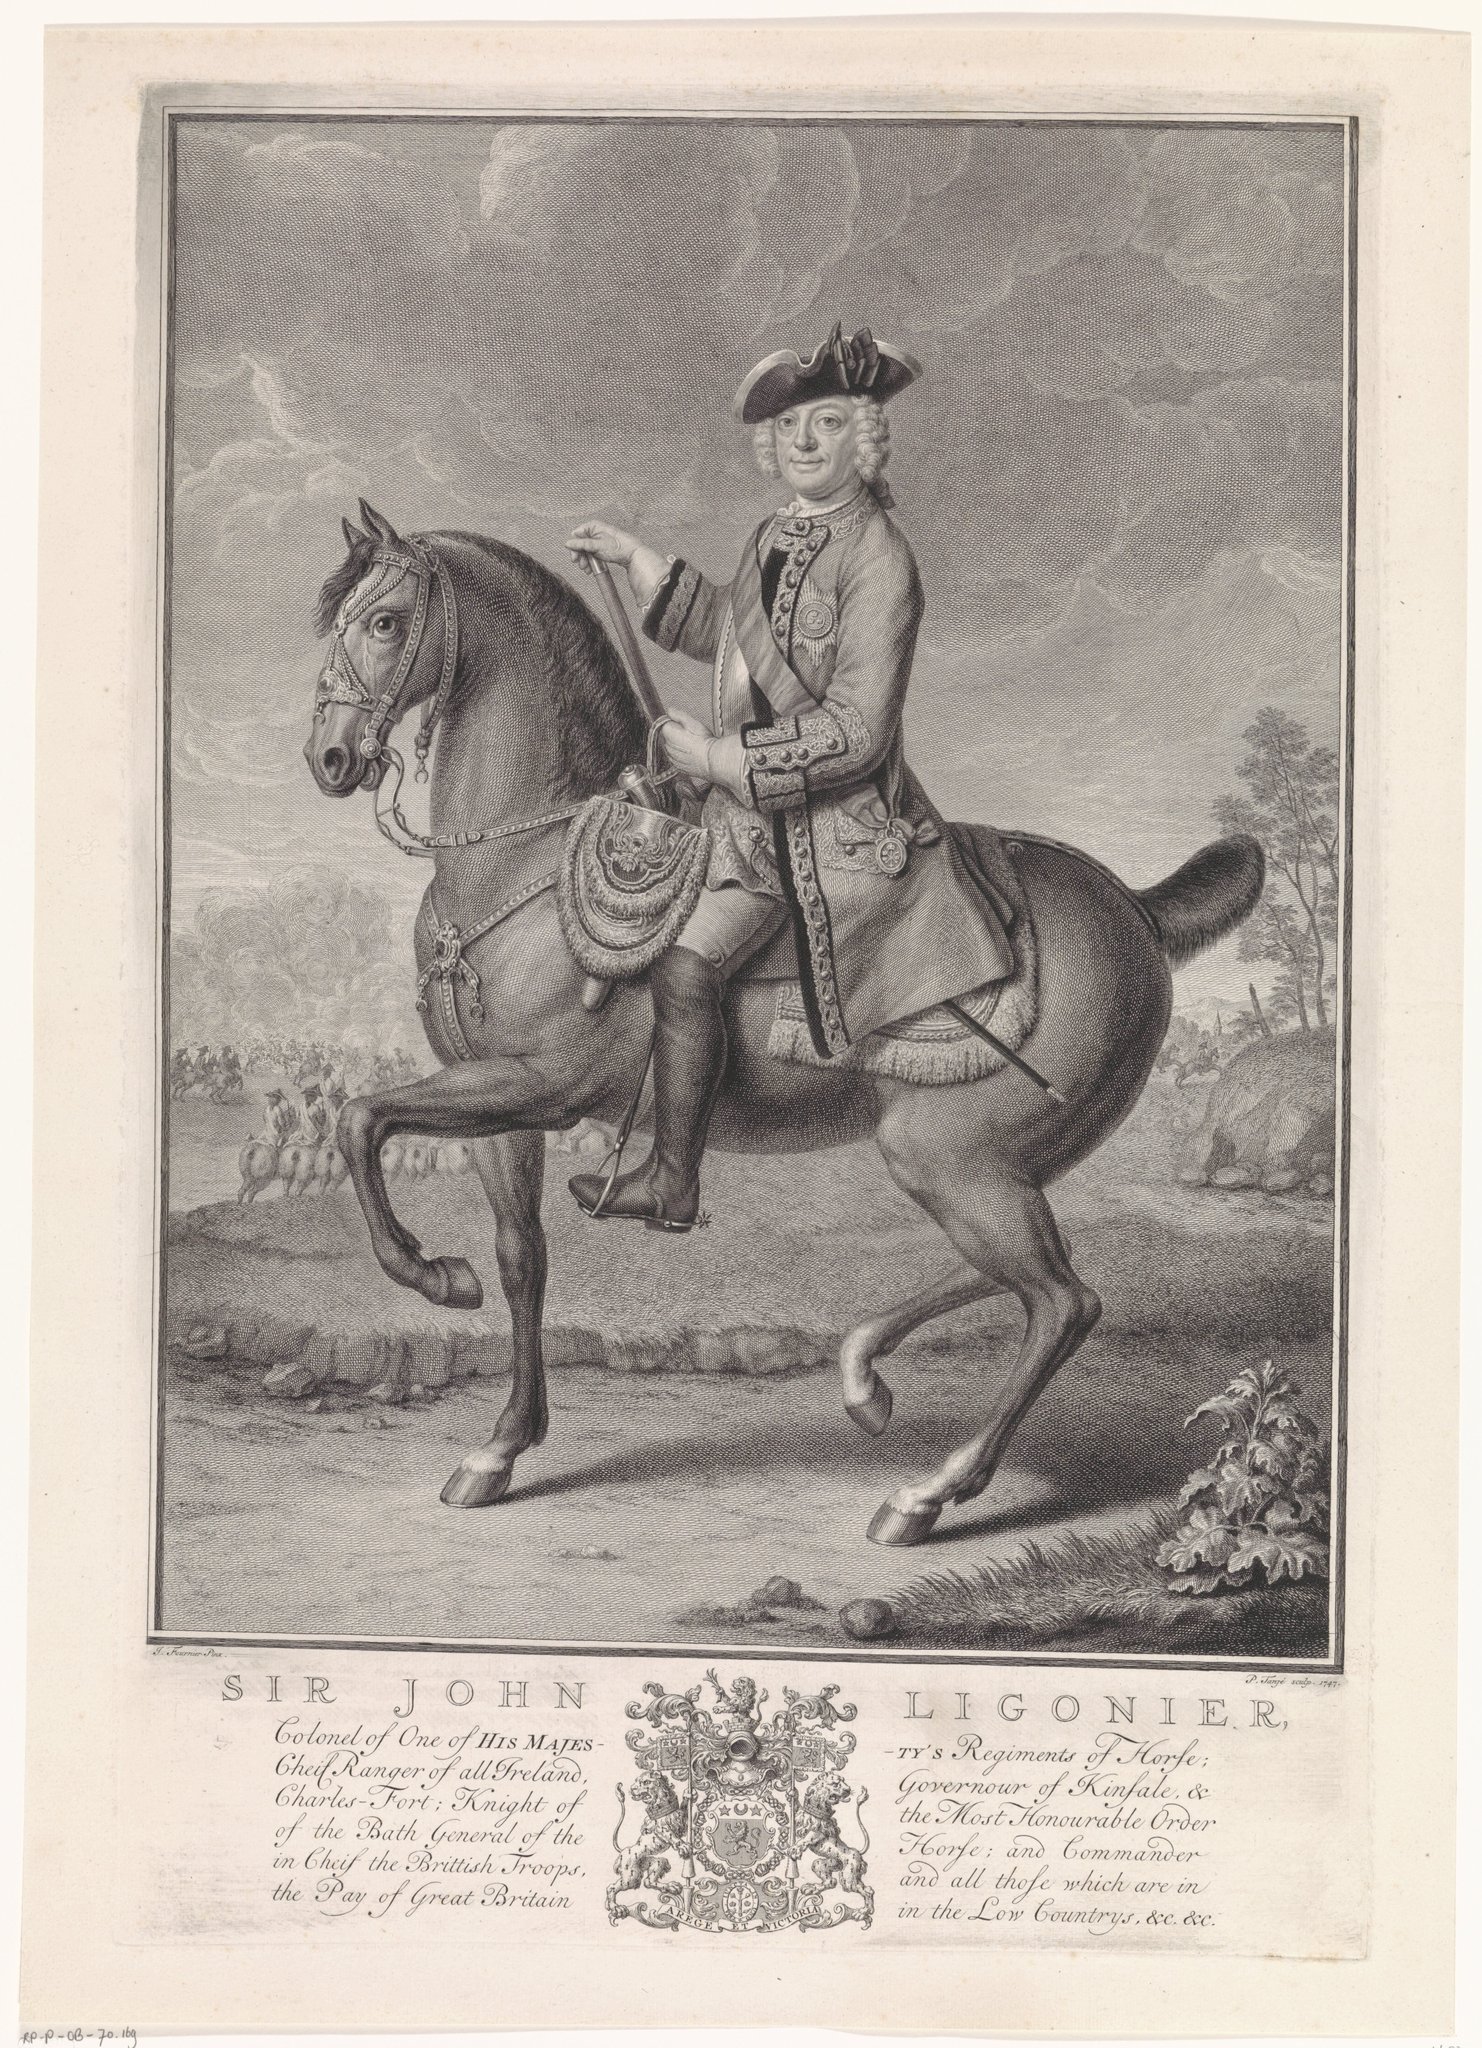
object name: print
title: Portret van John Ligonier te paard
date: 1747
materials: paper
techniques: engraving, etching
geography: amsterdam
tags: horse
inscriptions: collector's mark: Lugt 2228, collector's mark: Lugt 240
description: Portret van John Ligonier te paard met de commandostaf in zijn hand. Op de achtergrond een veldslag. John Ligonier was bevelhebber van het Engelse leger ten tijde van de Spaanse Succesieoorlog. Onderaan in de marge zijn wapenschild en een zesregelige tekst in het Engels.